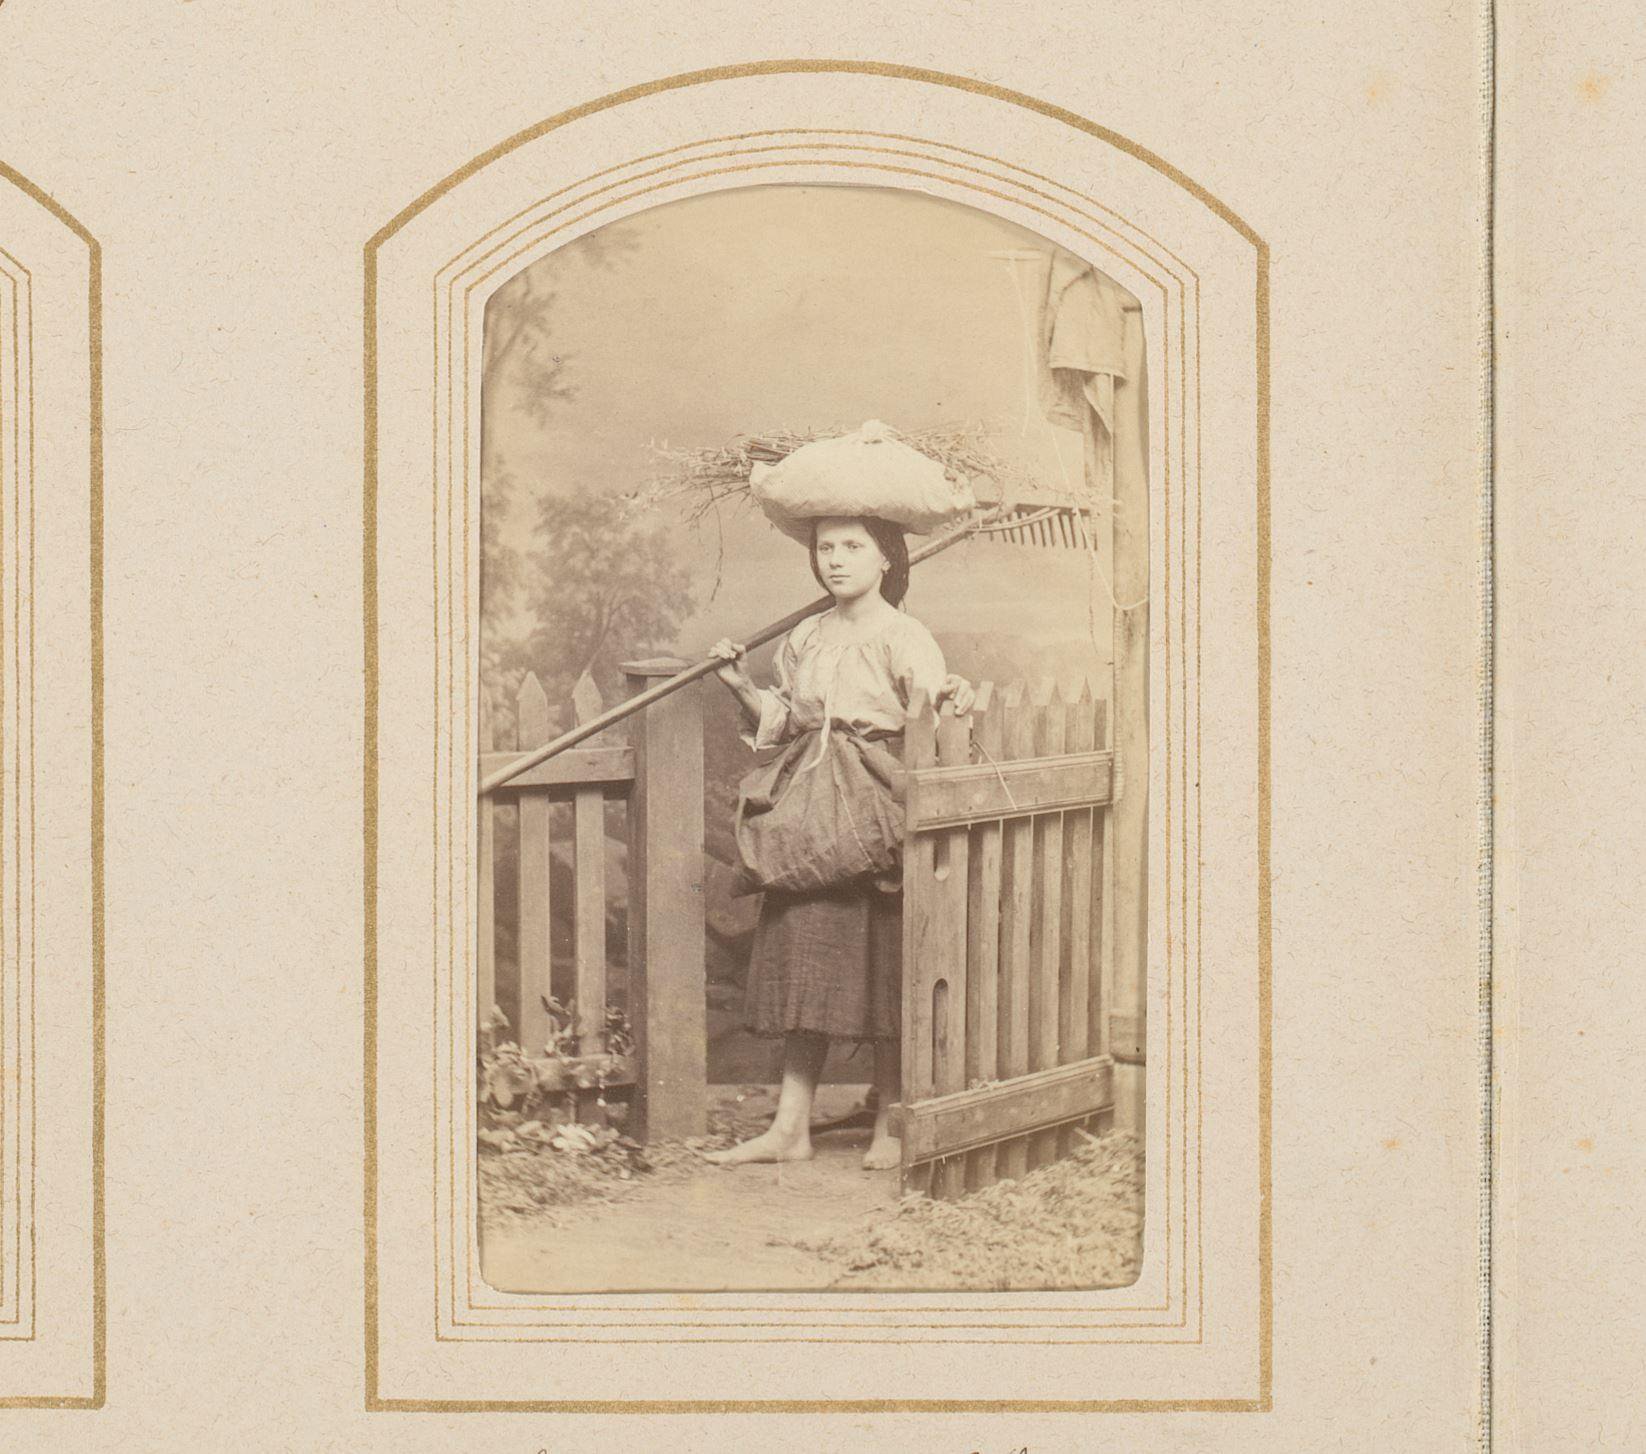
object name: album leaf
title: Die Heimkehr vom Velde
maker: Anonymous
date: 1870-1890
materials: cardboard, photographic support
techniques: albumen print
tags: farmers - aa - female farmer, farmer's wife, girl (child between toddler and youth), agricultural implements: rake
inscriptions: inscription: ‘1149’, annotation: ‘[...]’